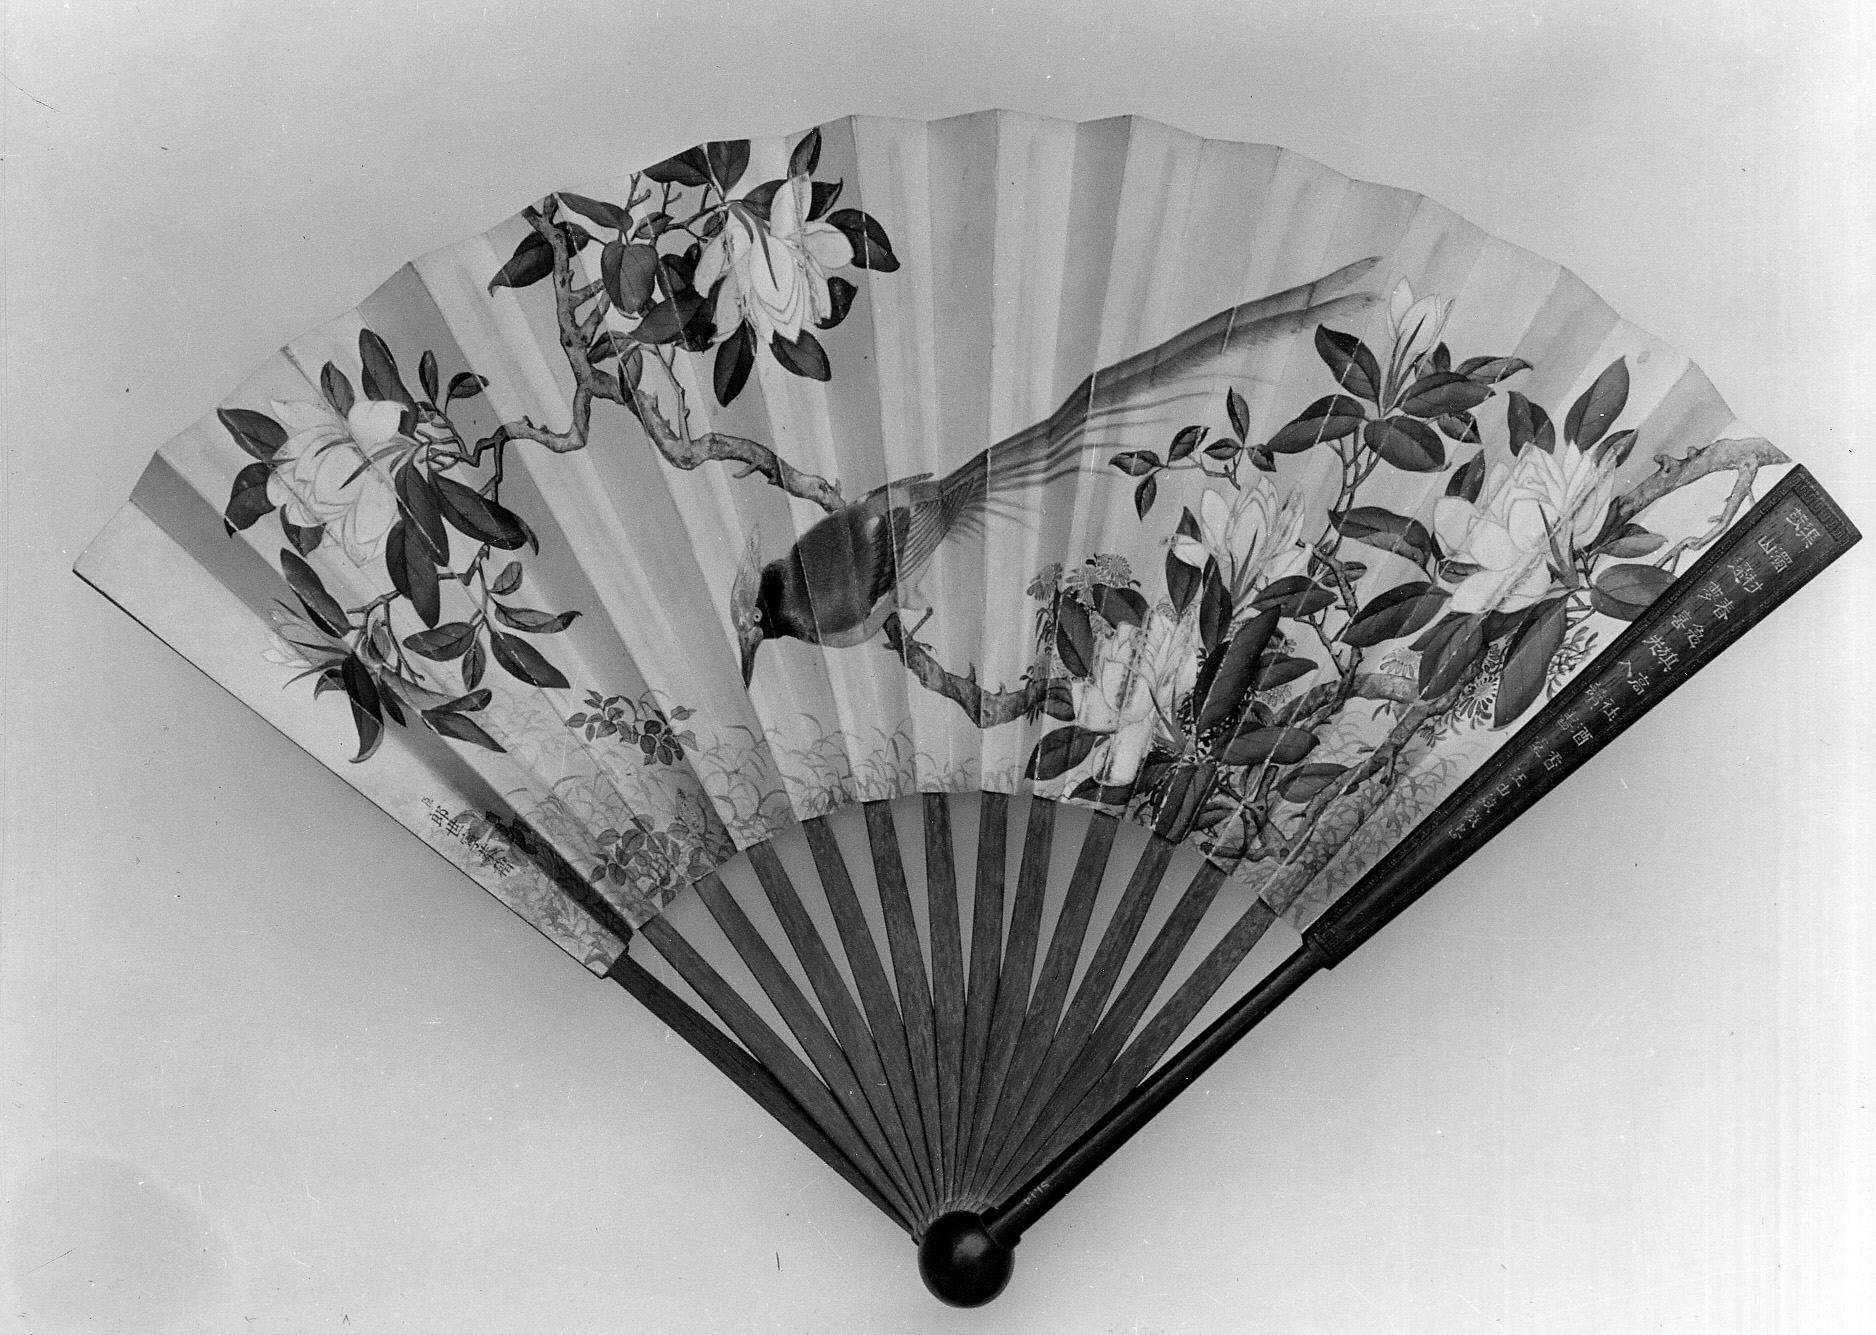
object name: folding fan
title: Fan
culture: chinese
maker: giuseppe castiglione (lang shining 郎世寧)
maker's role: artist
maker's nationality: italian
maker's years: 1688-1766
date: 1701-1800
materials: ink, paper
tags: birds,flowers